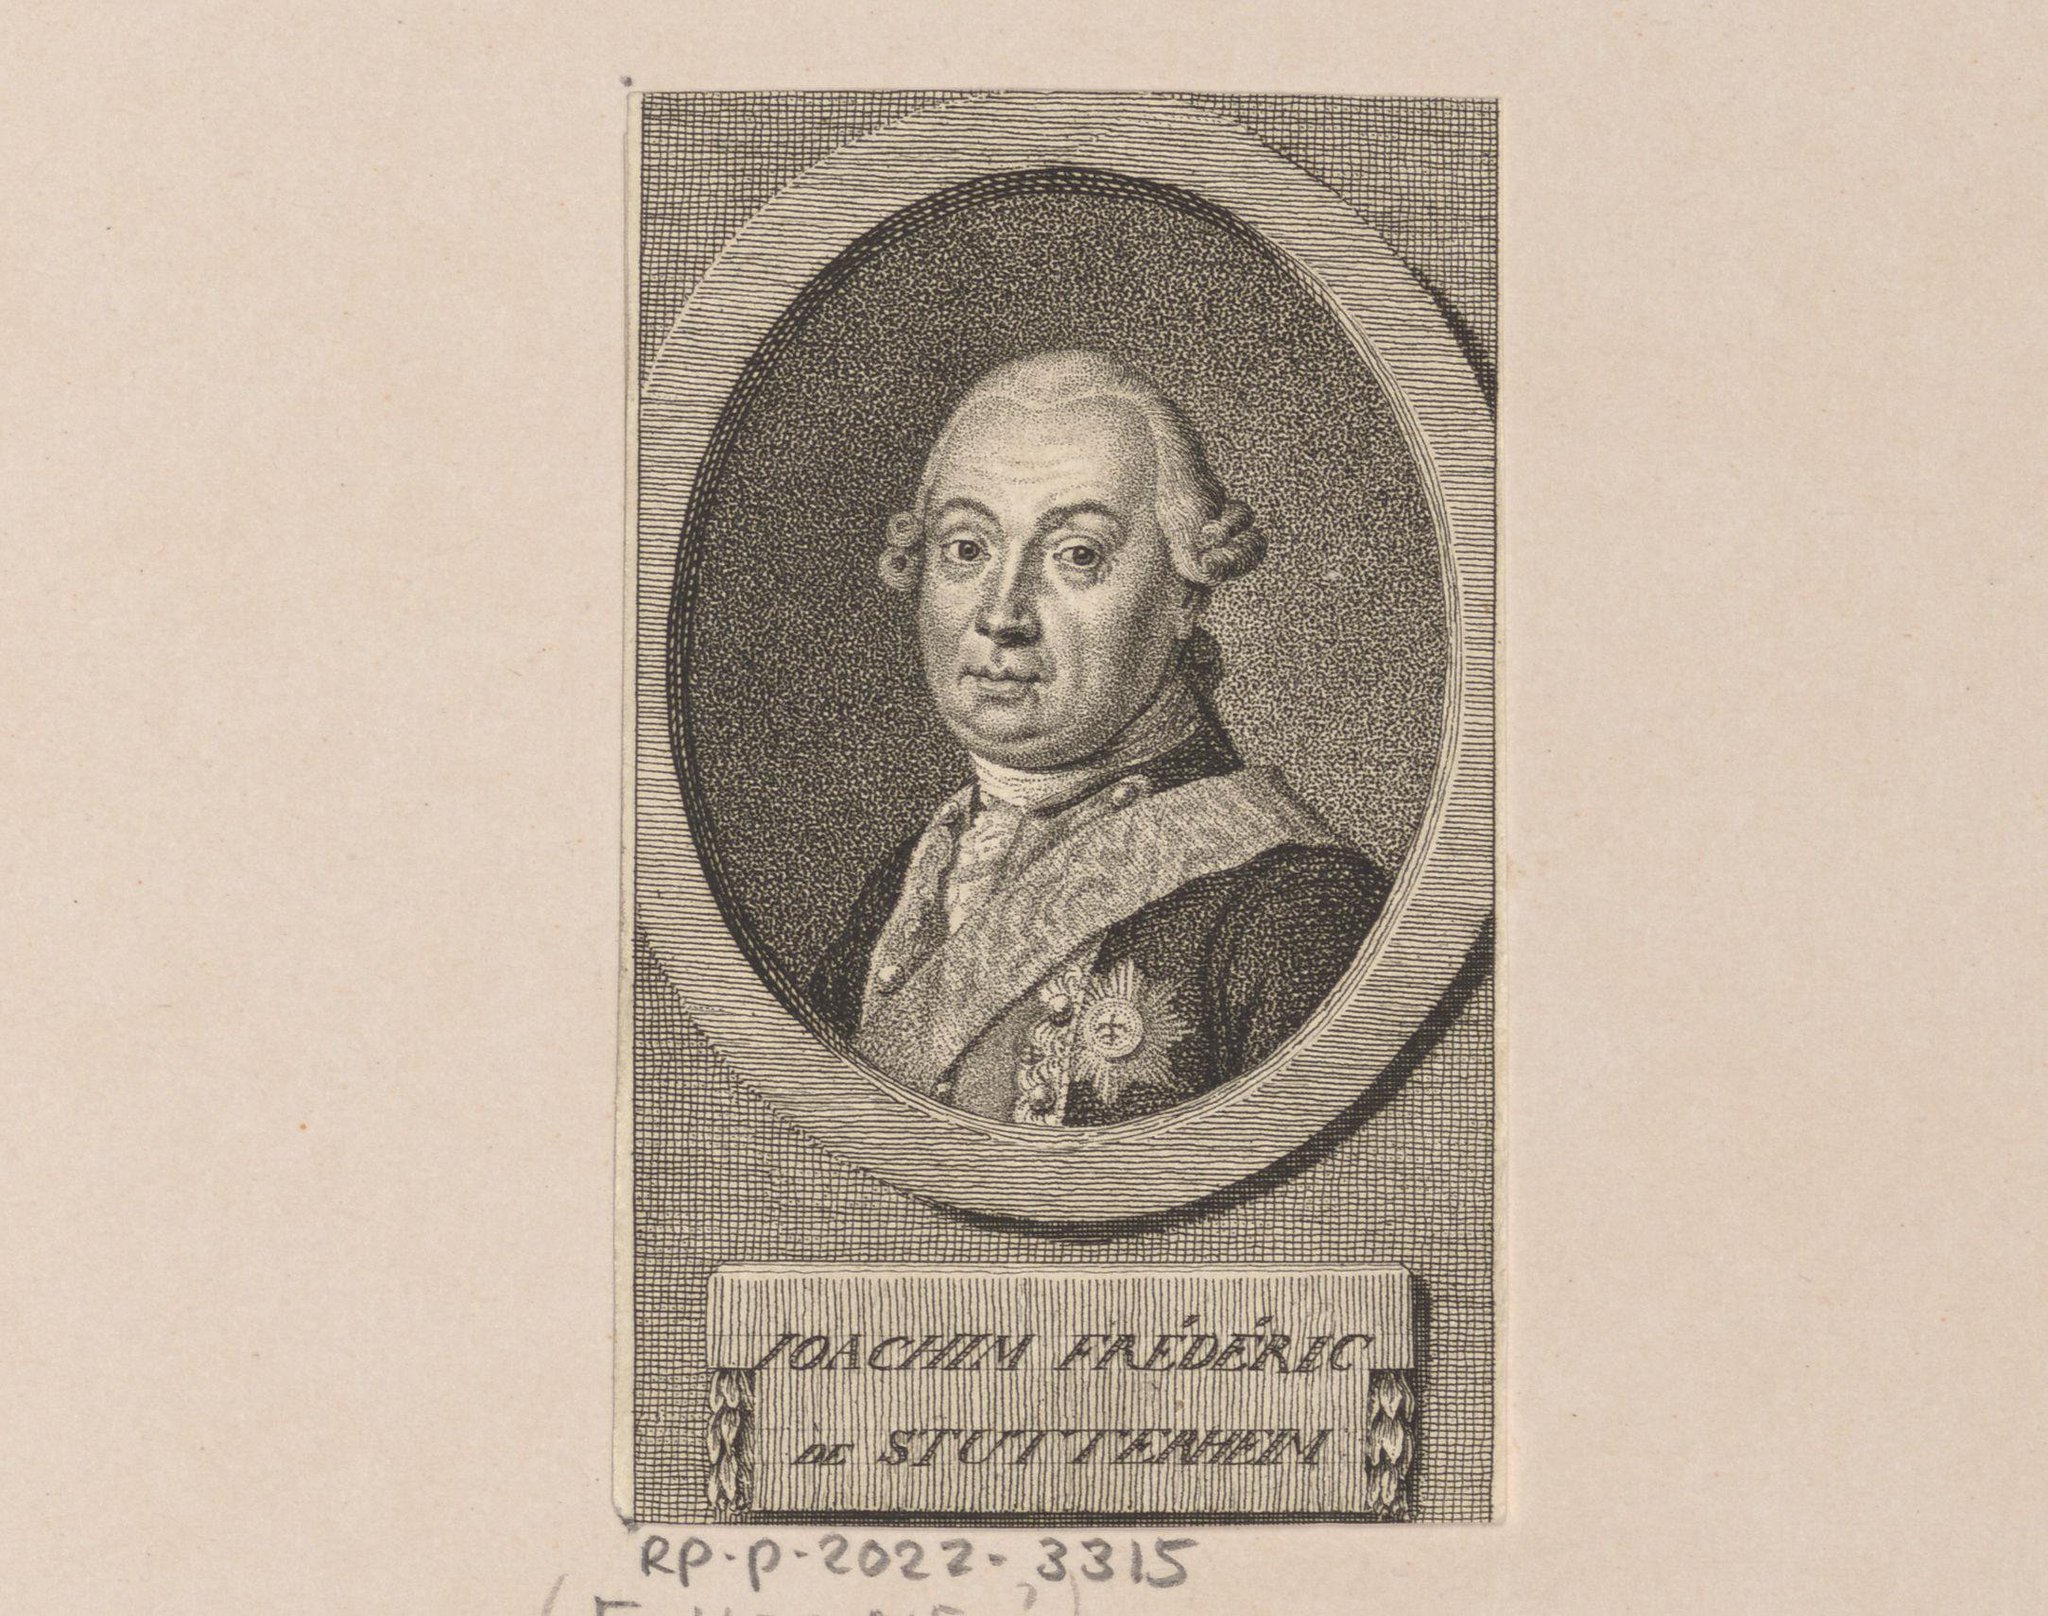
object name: print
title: Portret van Joachim Friedrich von Stutterheim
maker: Anonymous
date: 1760-1850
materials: paper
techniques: etching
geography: france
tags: commander-in-chief, general, marshal, historical persons